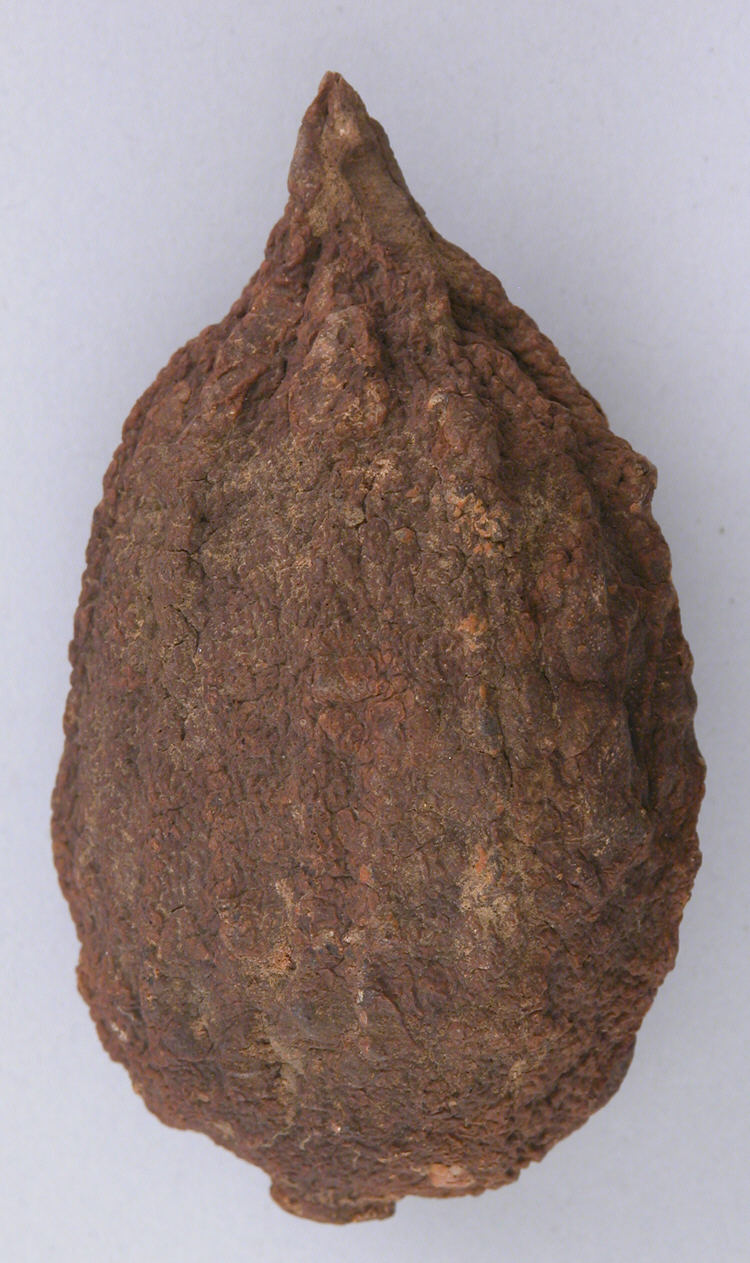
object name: petrified lemon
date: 201-1200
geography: egypt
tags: lemons